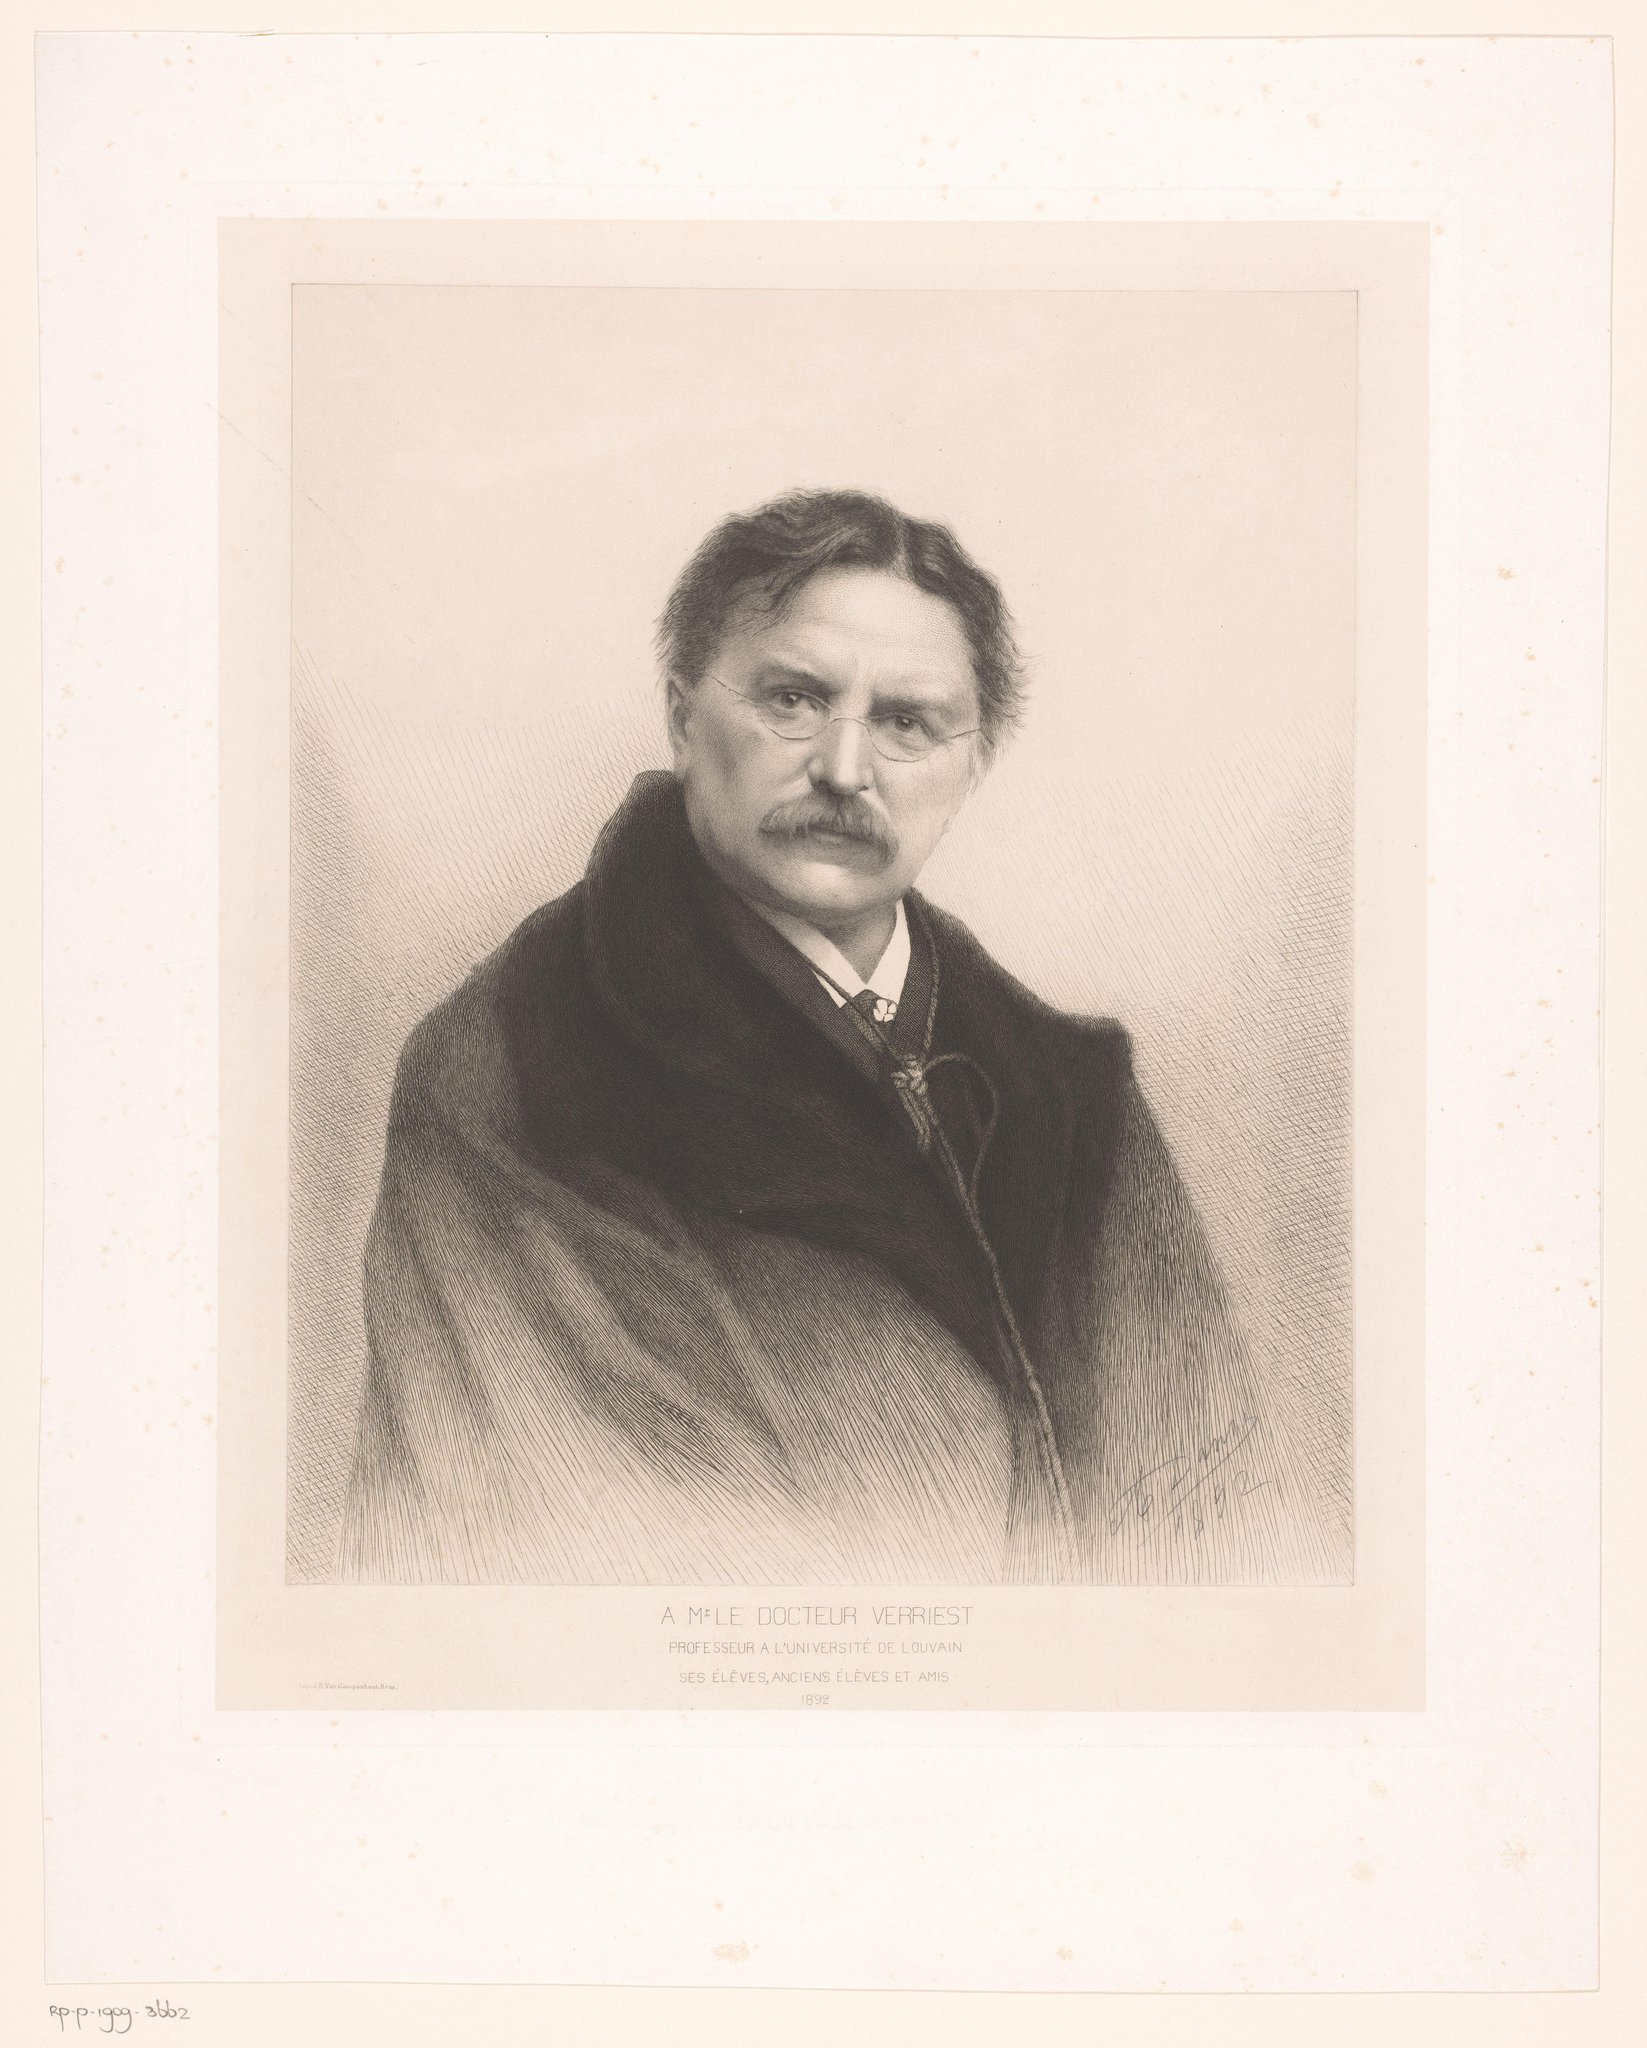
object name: print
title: A mr. le docteur Verriest professeur a l'université de Louvain ses élèves, anciens élèves et amis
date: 1892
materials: paper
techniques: drypoint, etching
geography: brussels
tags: historical person (...) - historical person (...) portrayed alone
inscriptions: collector's mark: Lugt 2228